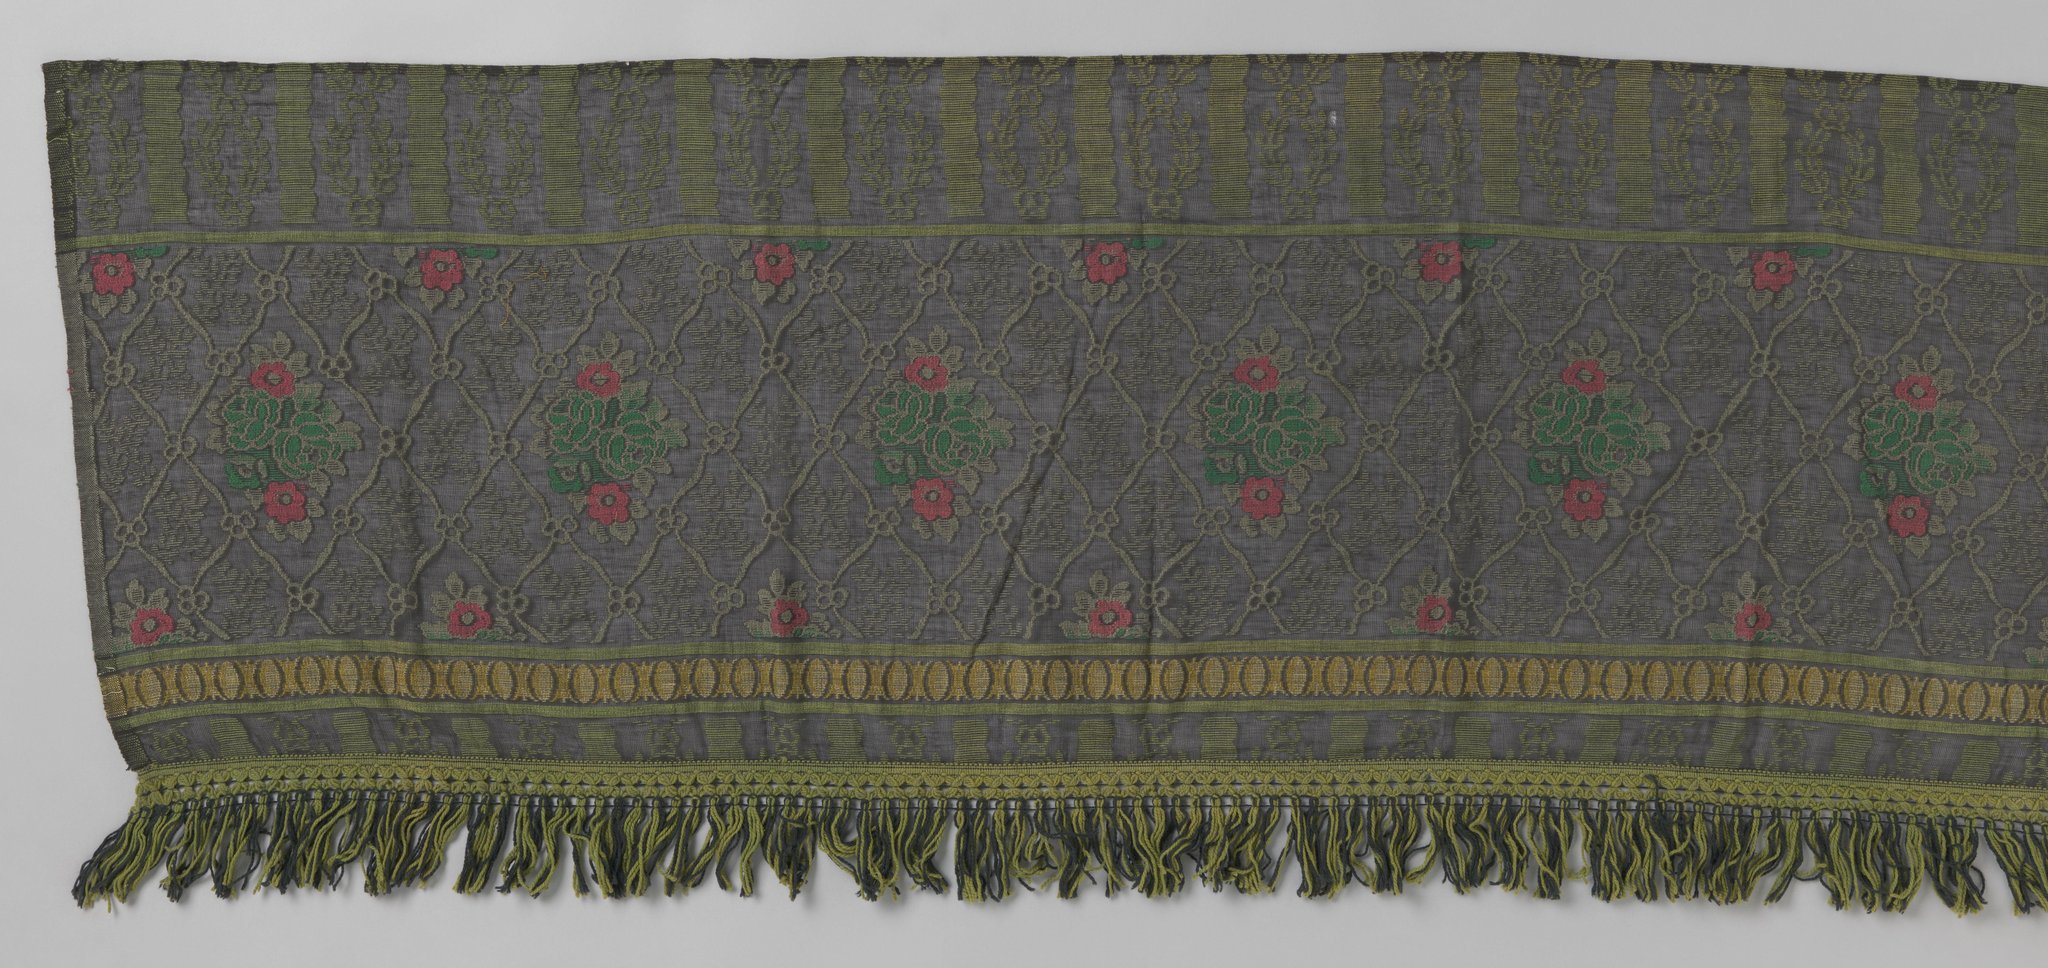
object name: gordijnval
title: Gordijnval voor een serre in zwart gaasweefsel, patroon "Madras".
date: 1920-1930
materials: textile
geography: ghent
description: Gordijnval voor een serre van madras in zwart gaasweefsel met bovenaan een band van groene verticale strepen en bladranken in ovaalvorm. Onderaan afboording in zelfde motief en lijstornament. Centraal groene rozen en rose bloemen tussen een ruitvormig patroon met bladranken in. Onderaan afgeboord met franjes in zwart en groen.